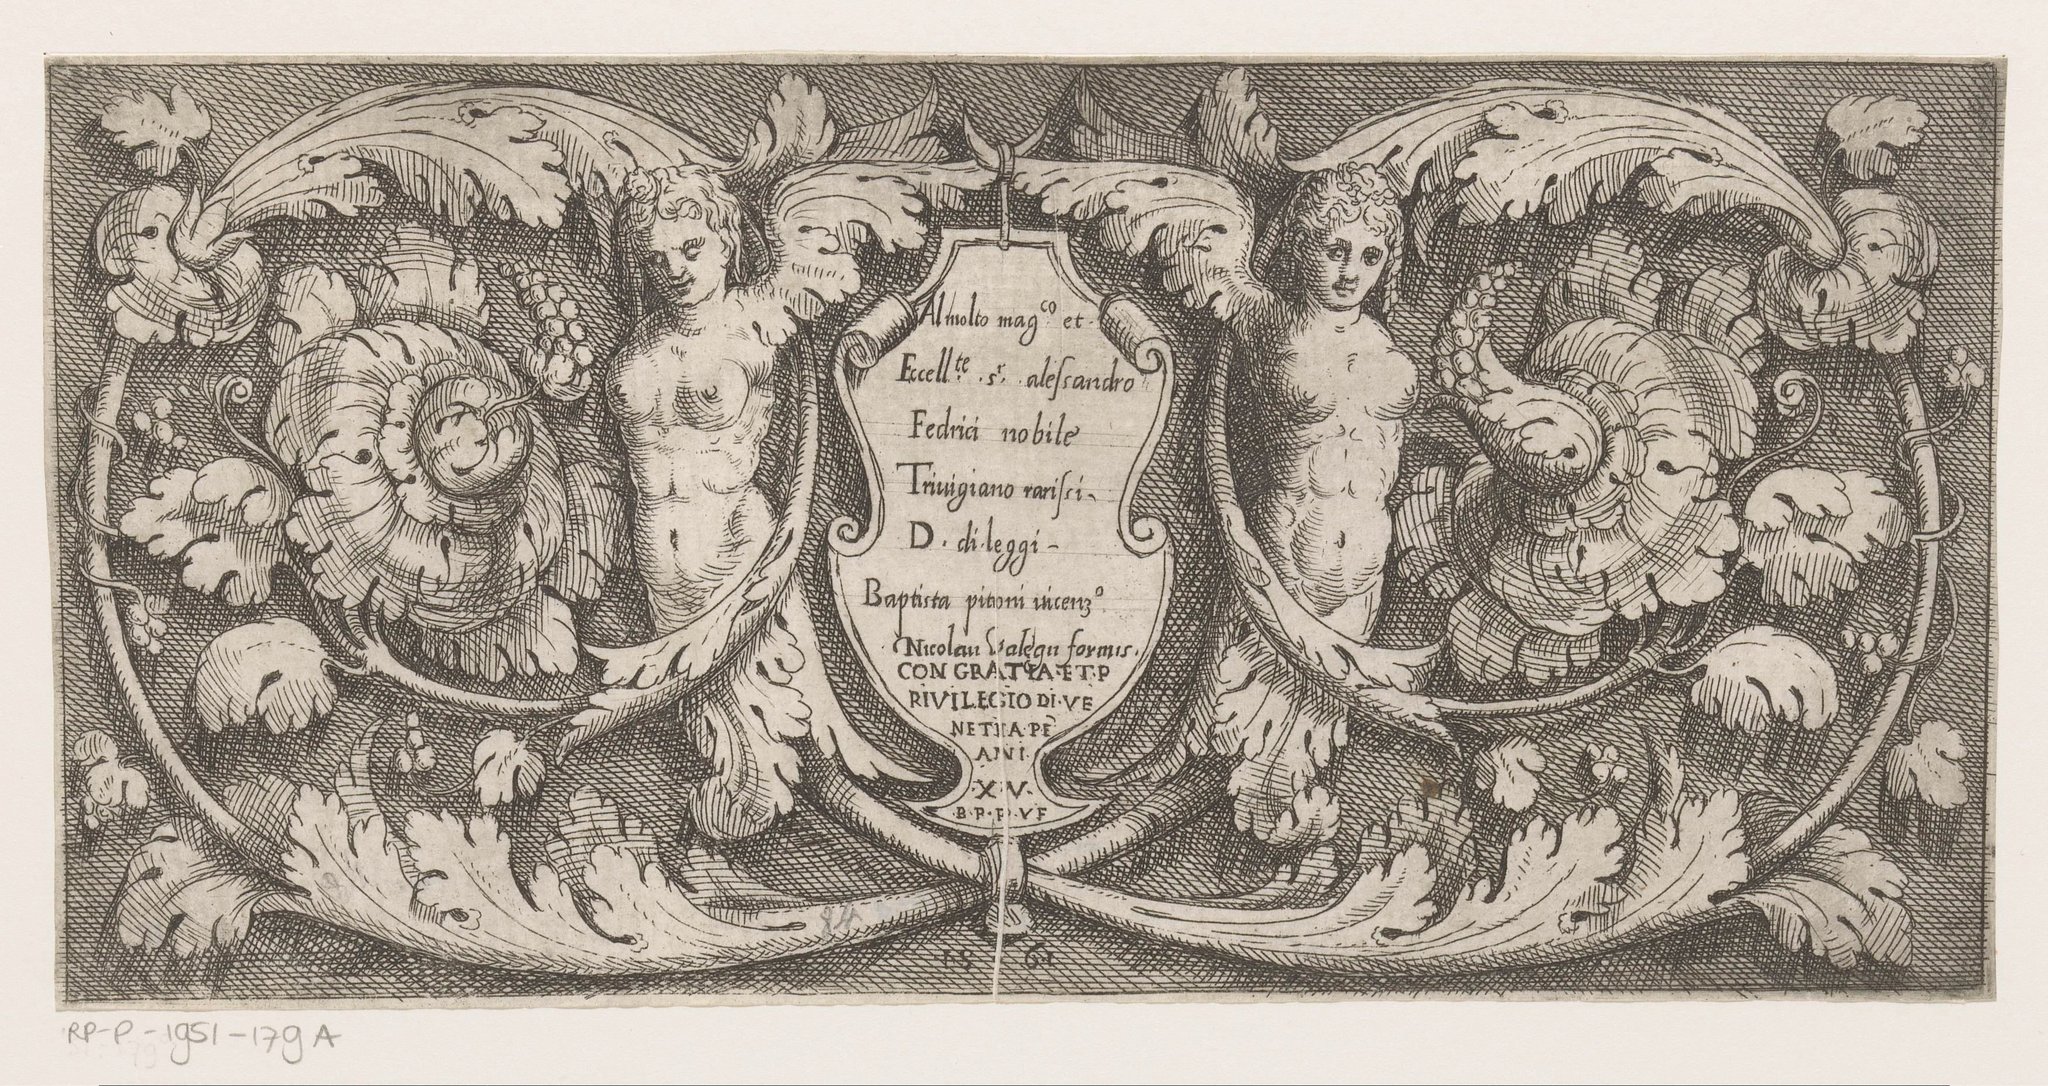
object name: ornament print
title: Fries met arabesken met twee gevleugelde vrouwenfiguren en cartouche met tekst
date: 1561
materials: paper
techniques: etching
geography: italy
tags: fabulous beings with wings - aa - female human figure, ornaments ~ art, foliage ~ ornament, ornament ~ cartouche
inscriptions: collector's mark: Lugt 2228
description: Deze prent maakt onderdeel uit van een reeks.